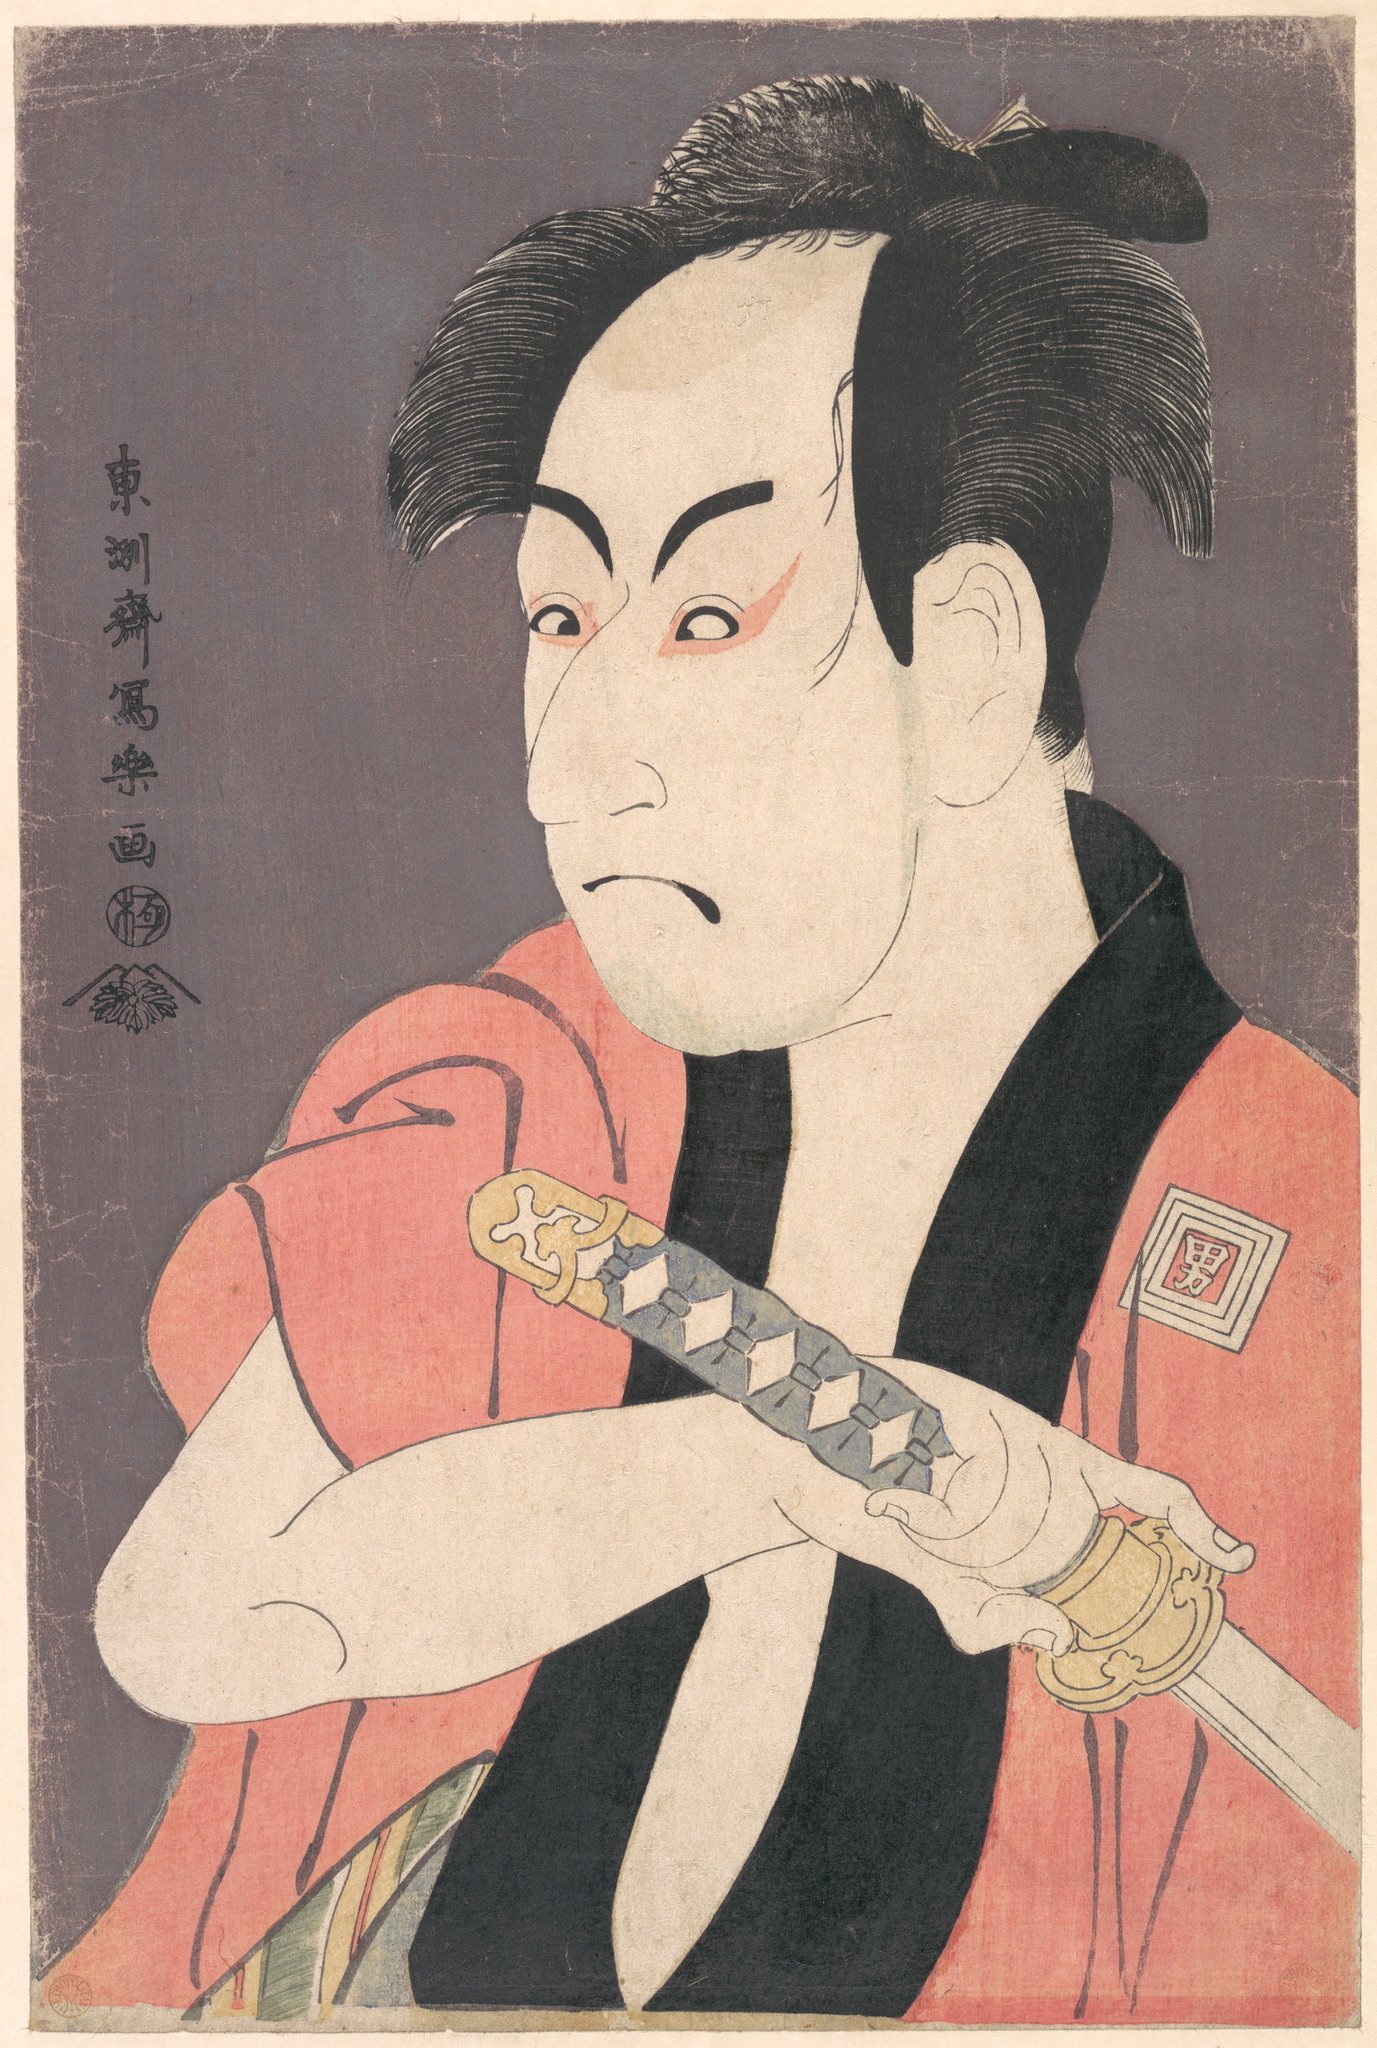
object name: print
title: Ichikawa Omezō I in the Role of Yakko Ippei from the Play "Koinyōbō somewake tazuna"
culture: japanese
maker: tōshūsai sharaku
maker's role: artist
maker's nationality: japanese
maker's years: 1794-1795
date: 1794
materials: ink, mica, paper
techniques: woodblock print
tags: swords,men,actors